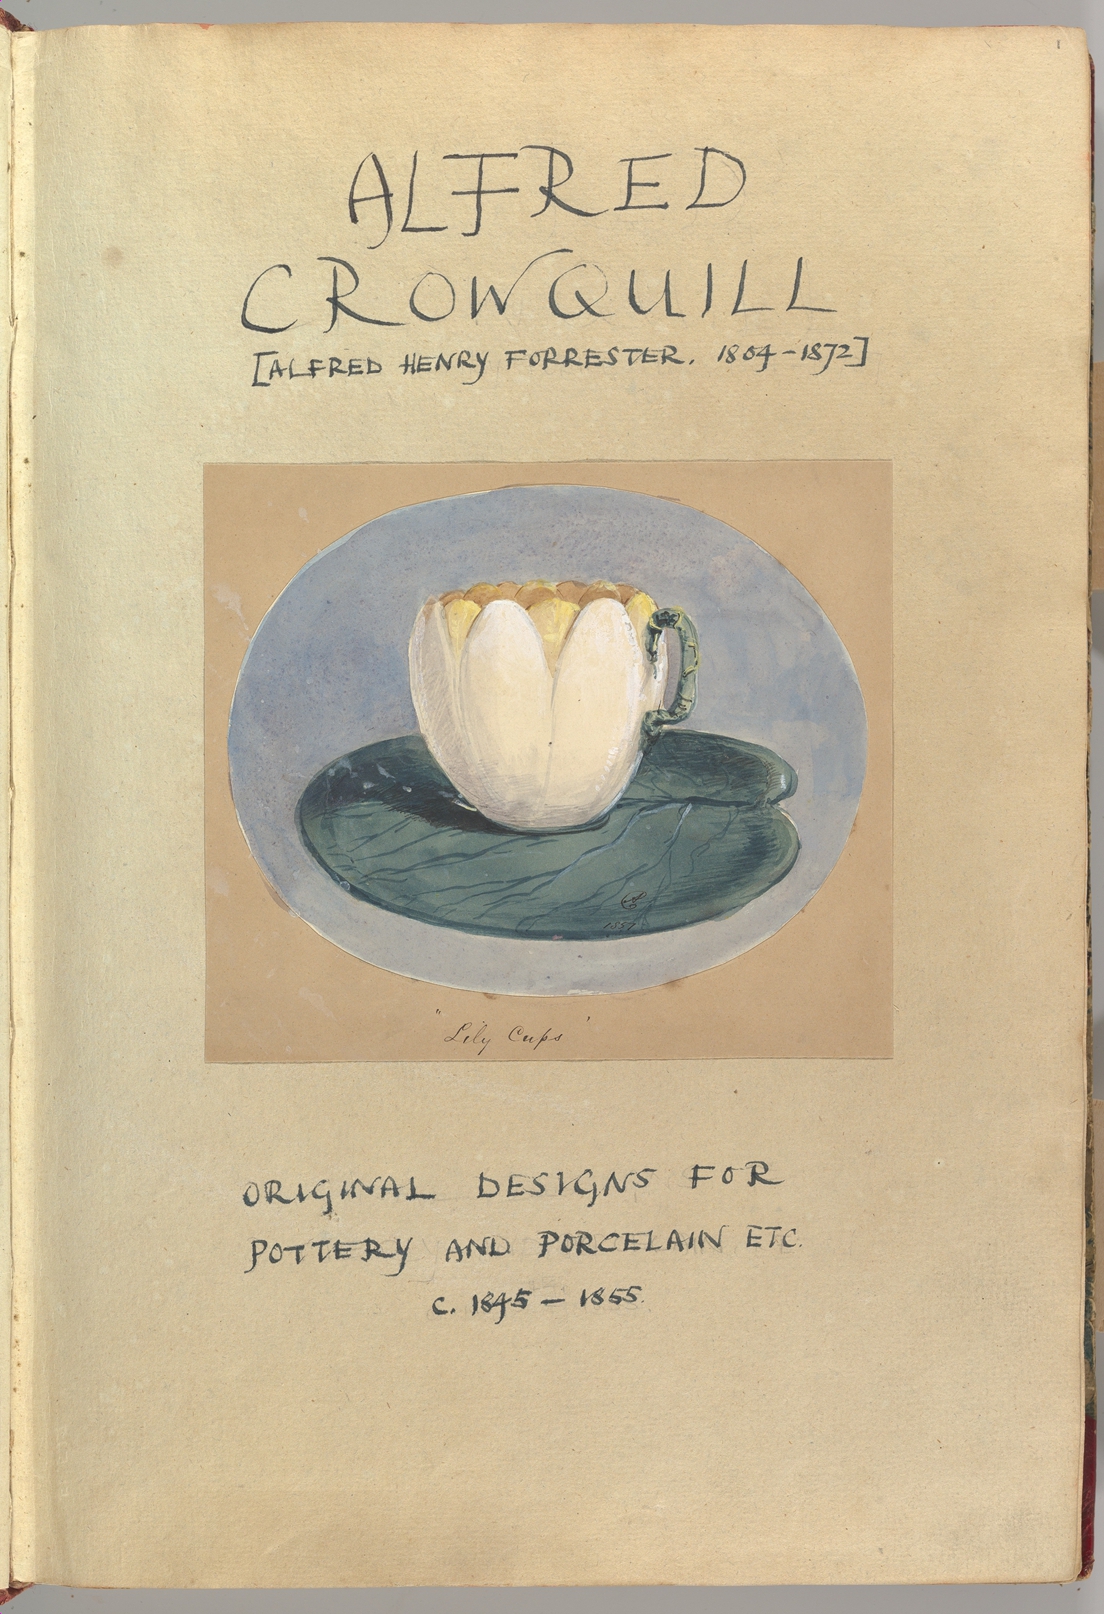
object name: drawing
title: Drawn title page inscribed "Alfred Crowquill [Alfred Henry Forrester, 1804–1872], Original Designs for Pottery and Porcelain, ca. 1845–1855," with Drawing of Lily Cup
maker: alfred henry forrester [alfred crowquill]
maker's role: artist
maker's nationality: british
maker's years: 1804-1872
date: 1845-1855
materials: gouache, ink, watercolor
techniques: pen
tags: lilies,cups